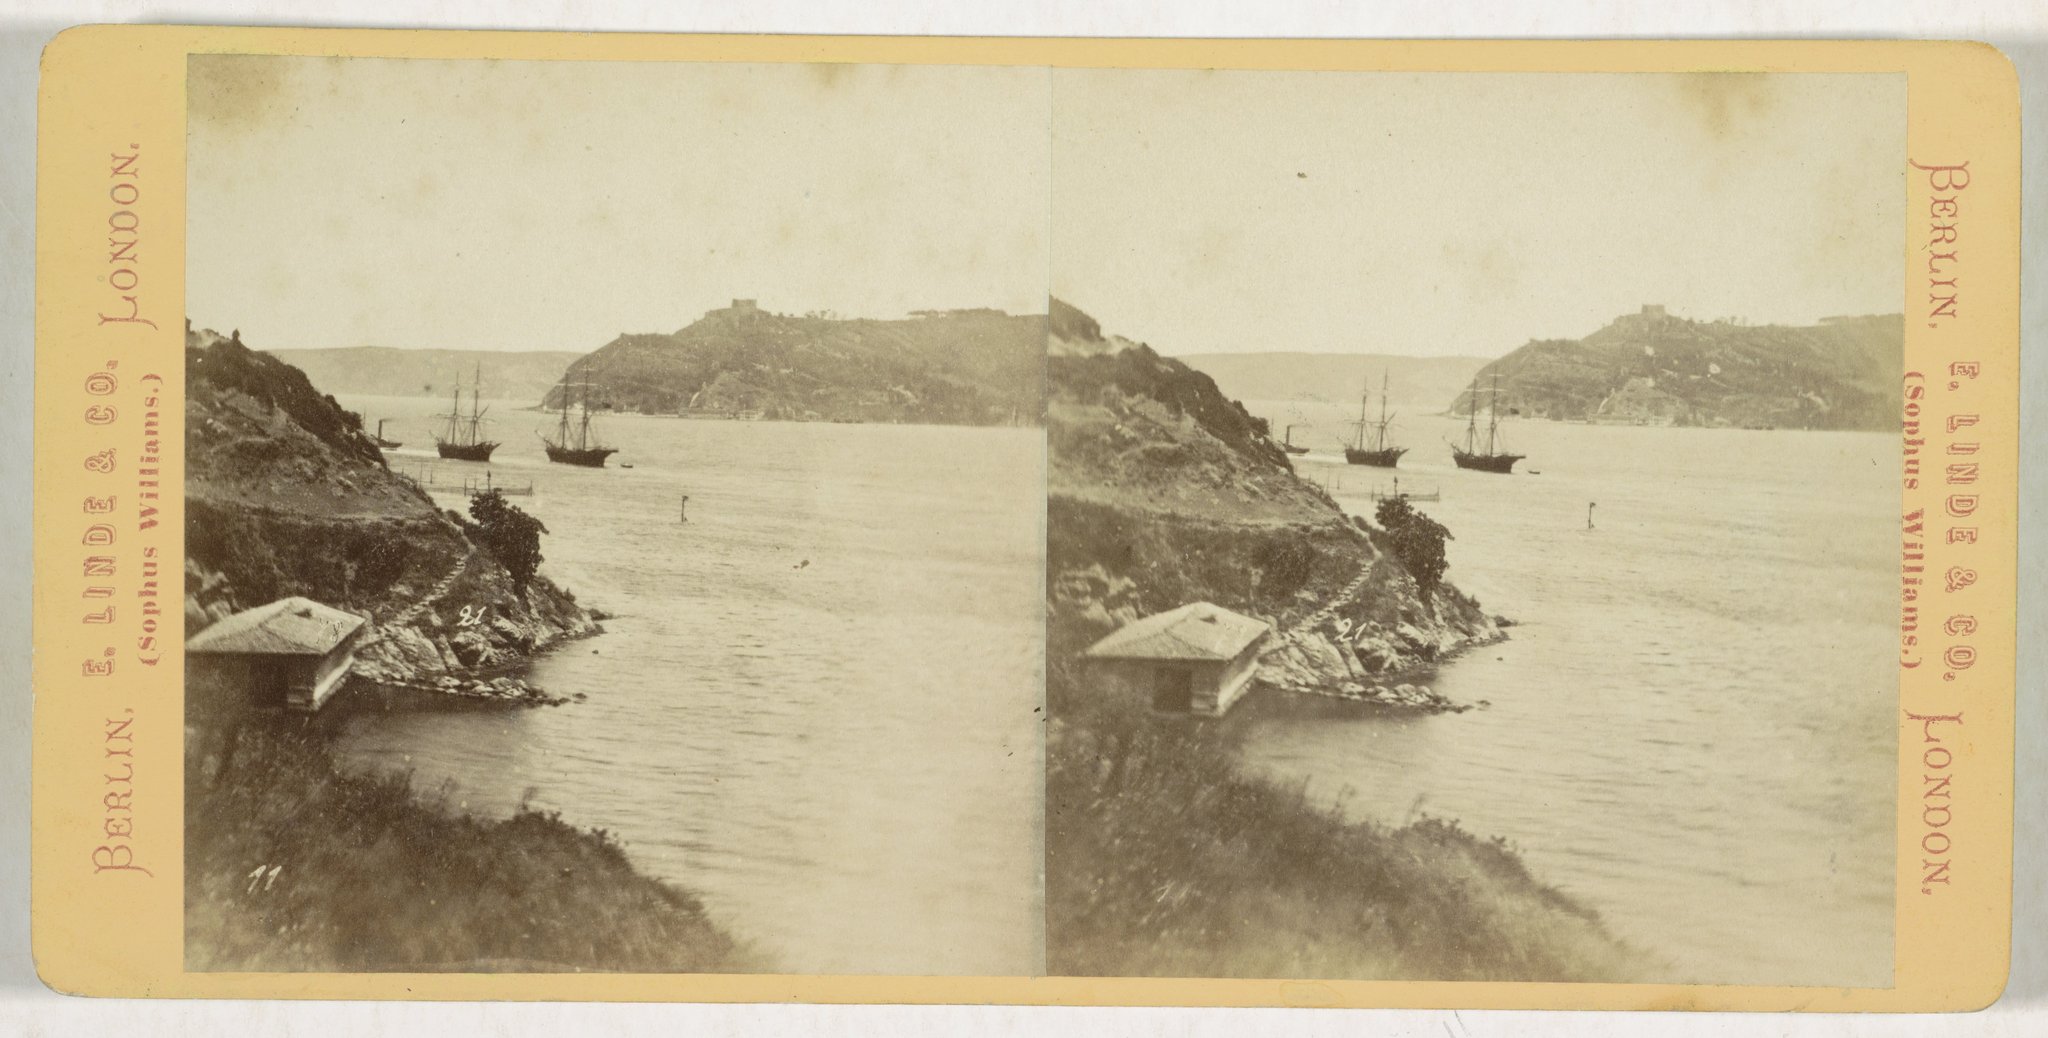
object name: stereograph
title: Einfahrt ins Schwarze Meer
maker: Anonymous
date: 1873-1890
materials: cardboard, paper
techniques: albumen print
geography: berlin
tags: sea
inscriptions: number: ‘11’